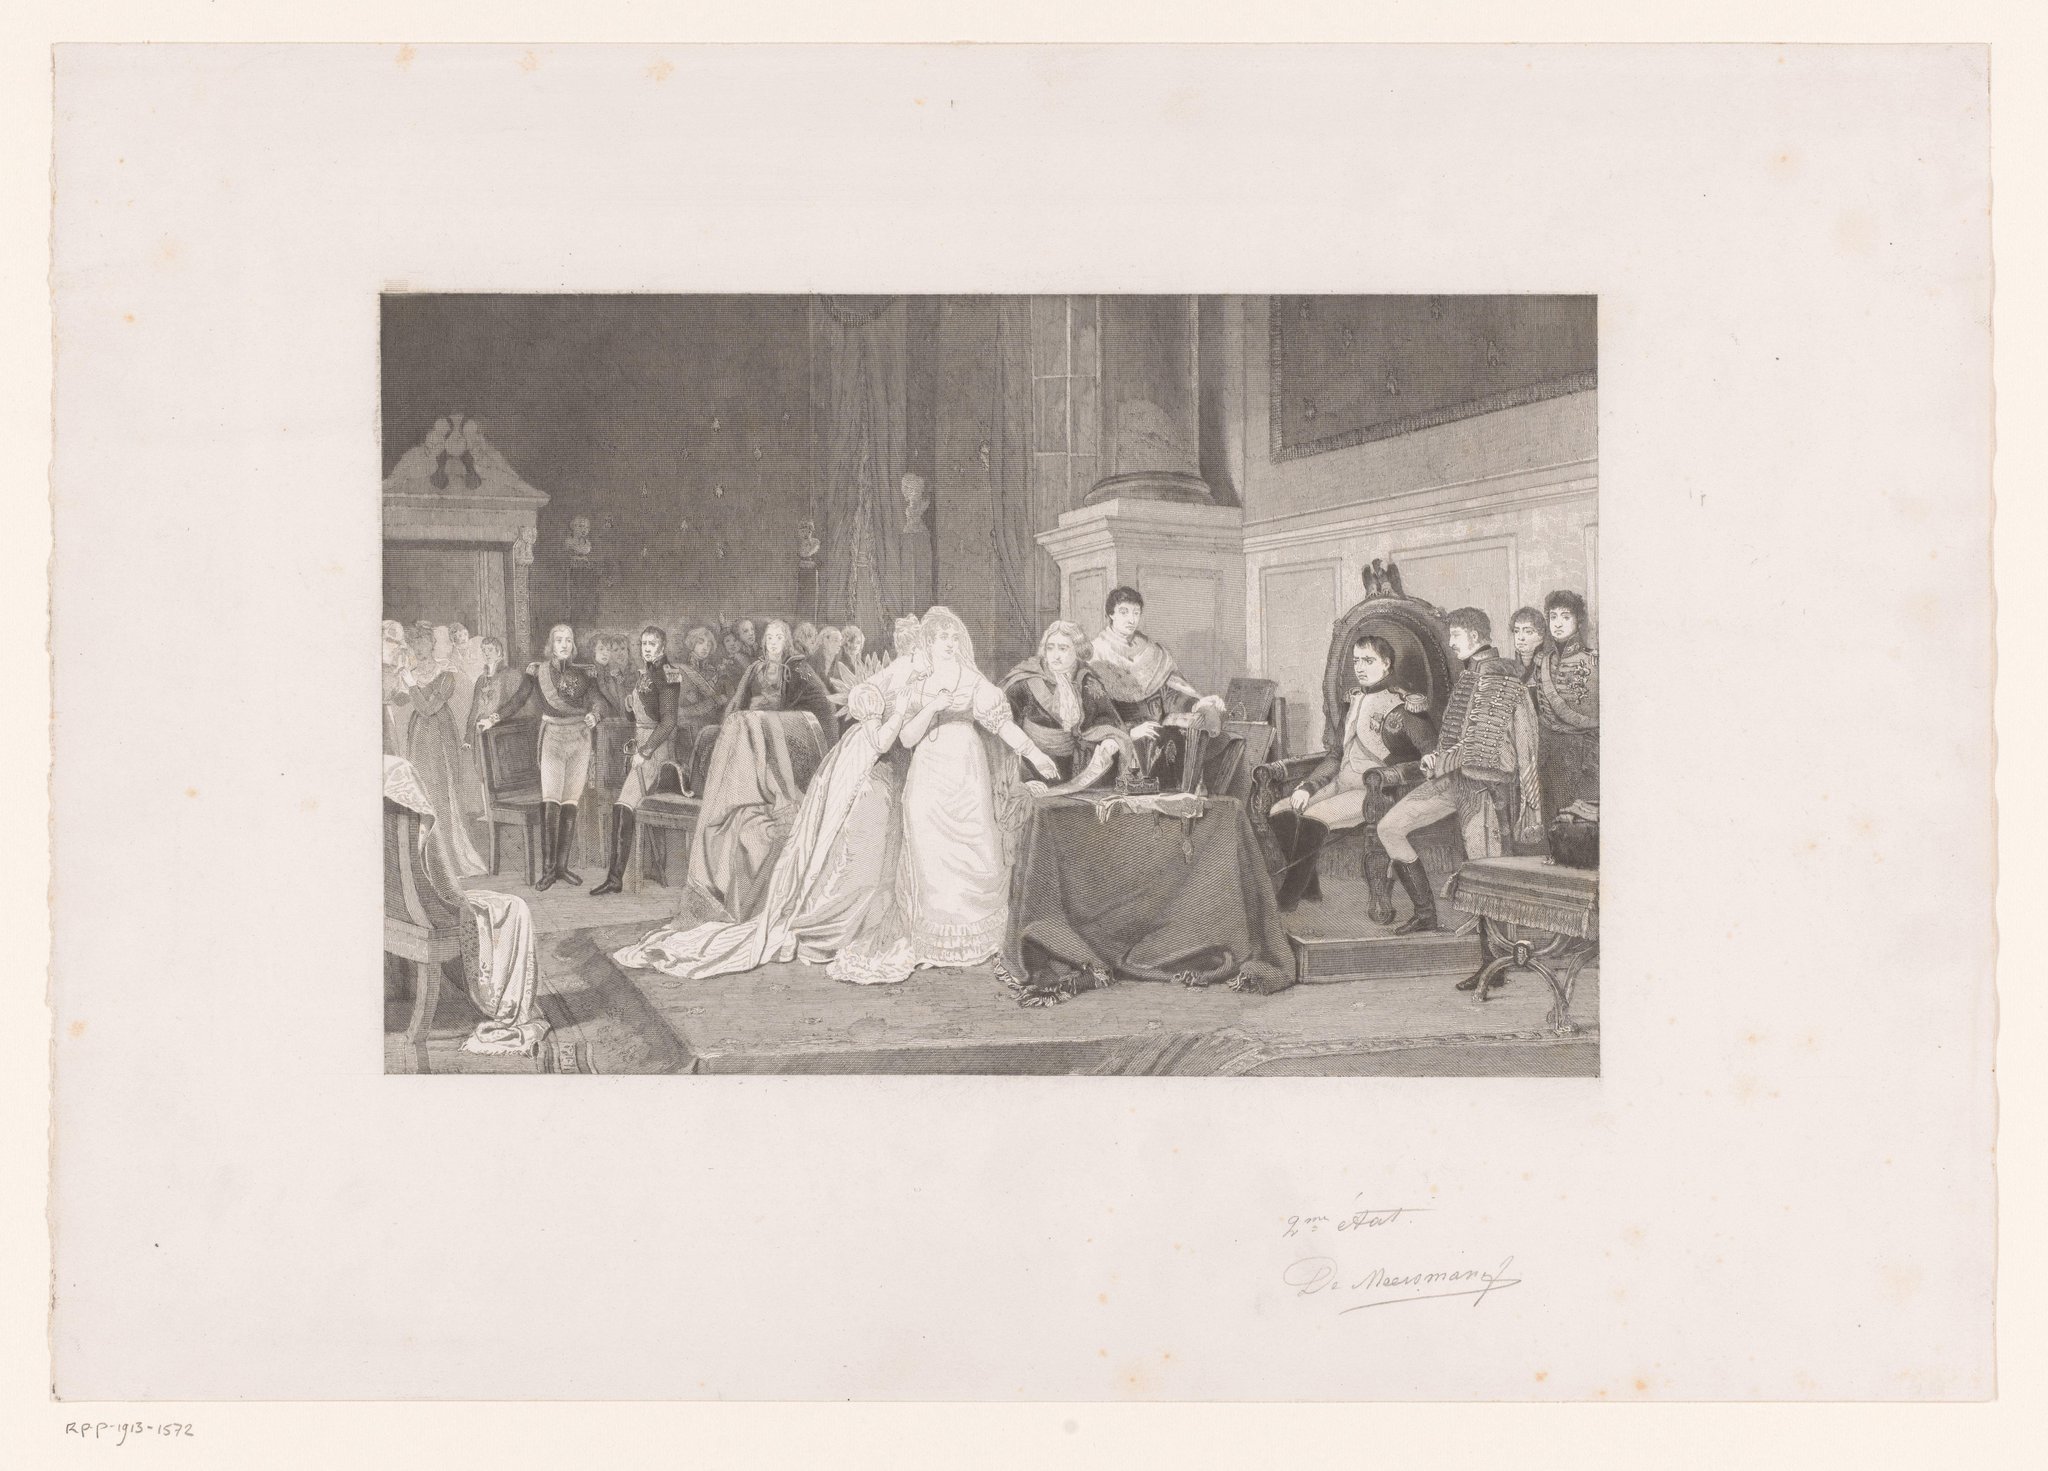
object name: print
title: Scheiding van Napoleon en Joséphine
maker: françois de meersman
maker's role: print maker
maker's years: 1830-1905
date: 1840-1905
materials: paper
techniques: engraving, etching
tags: joséphine de beauharnais, napoleon i (emperor of the french), divorce, throne-room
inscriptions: collector's mark: Lugt 2228, inscription: ‘2 me état’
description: Napoleon verbrak het huwelijk tussen hem en Joséphine in 1809 omdat het huwelijk kinderloos bleef. Hij hertrouwde in 1810.